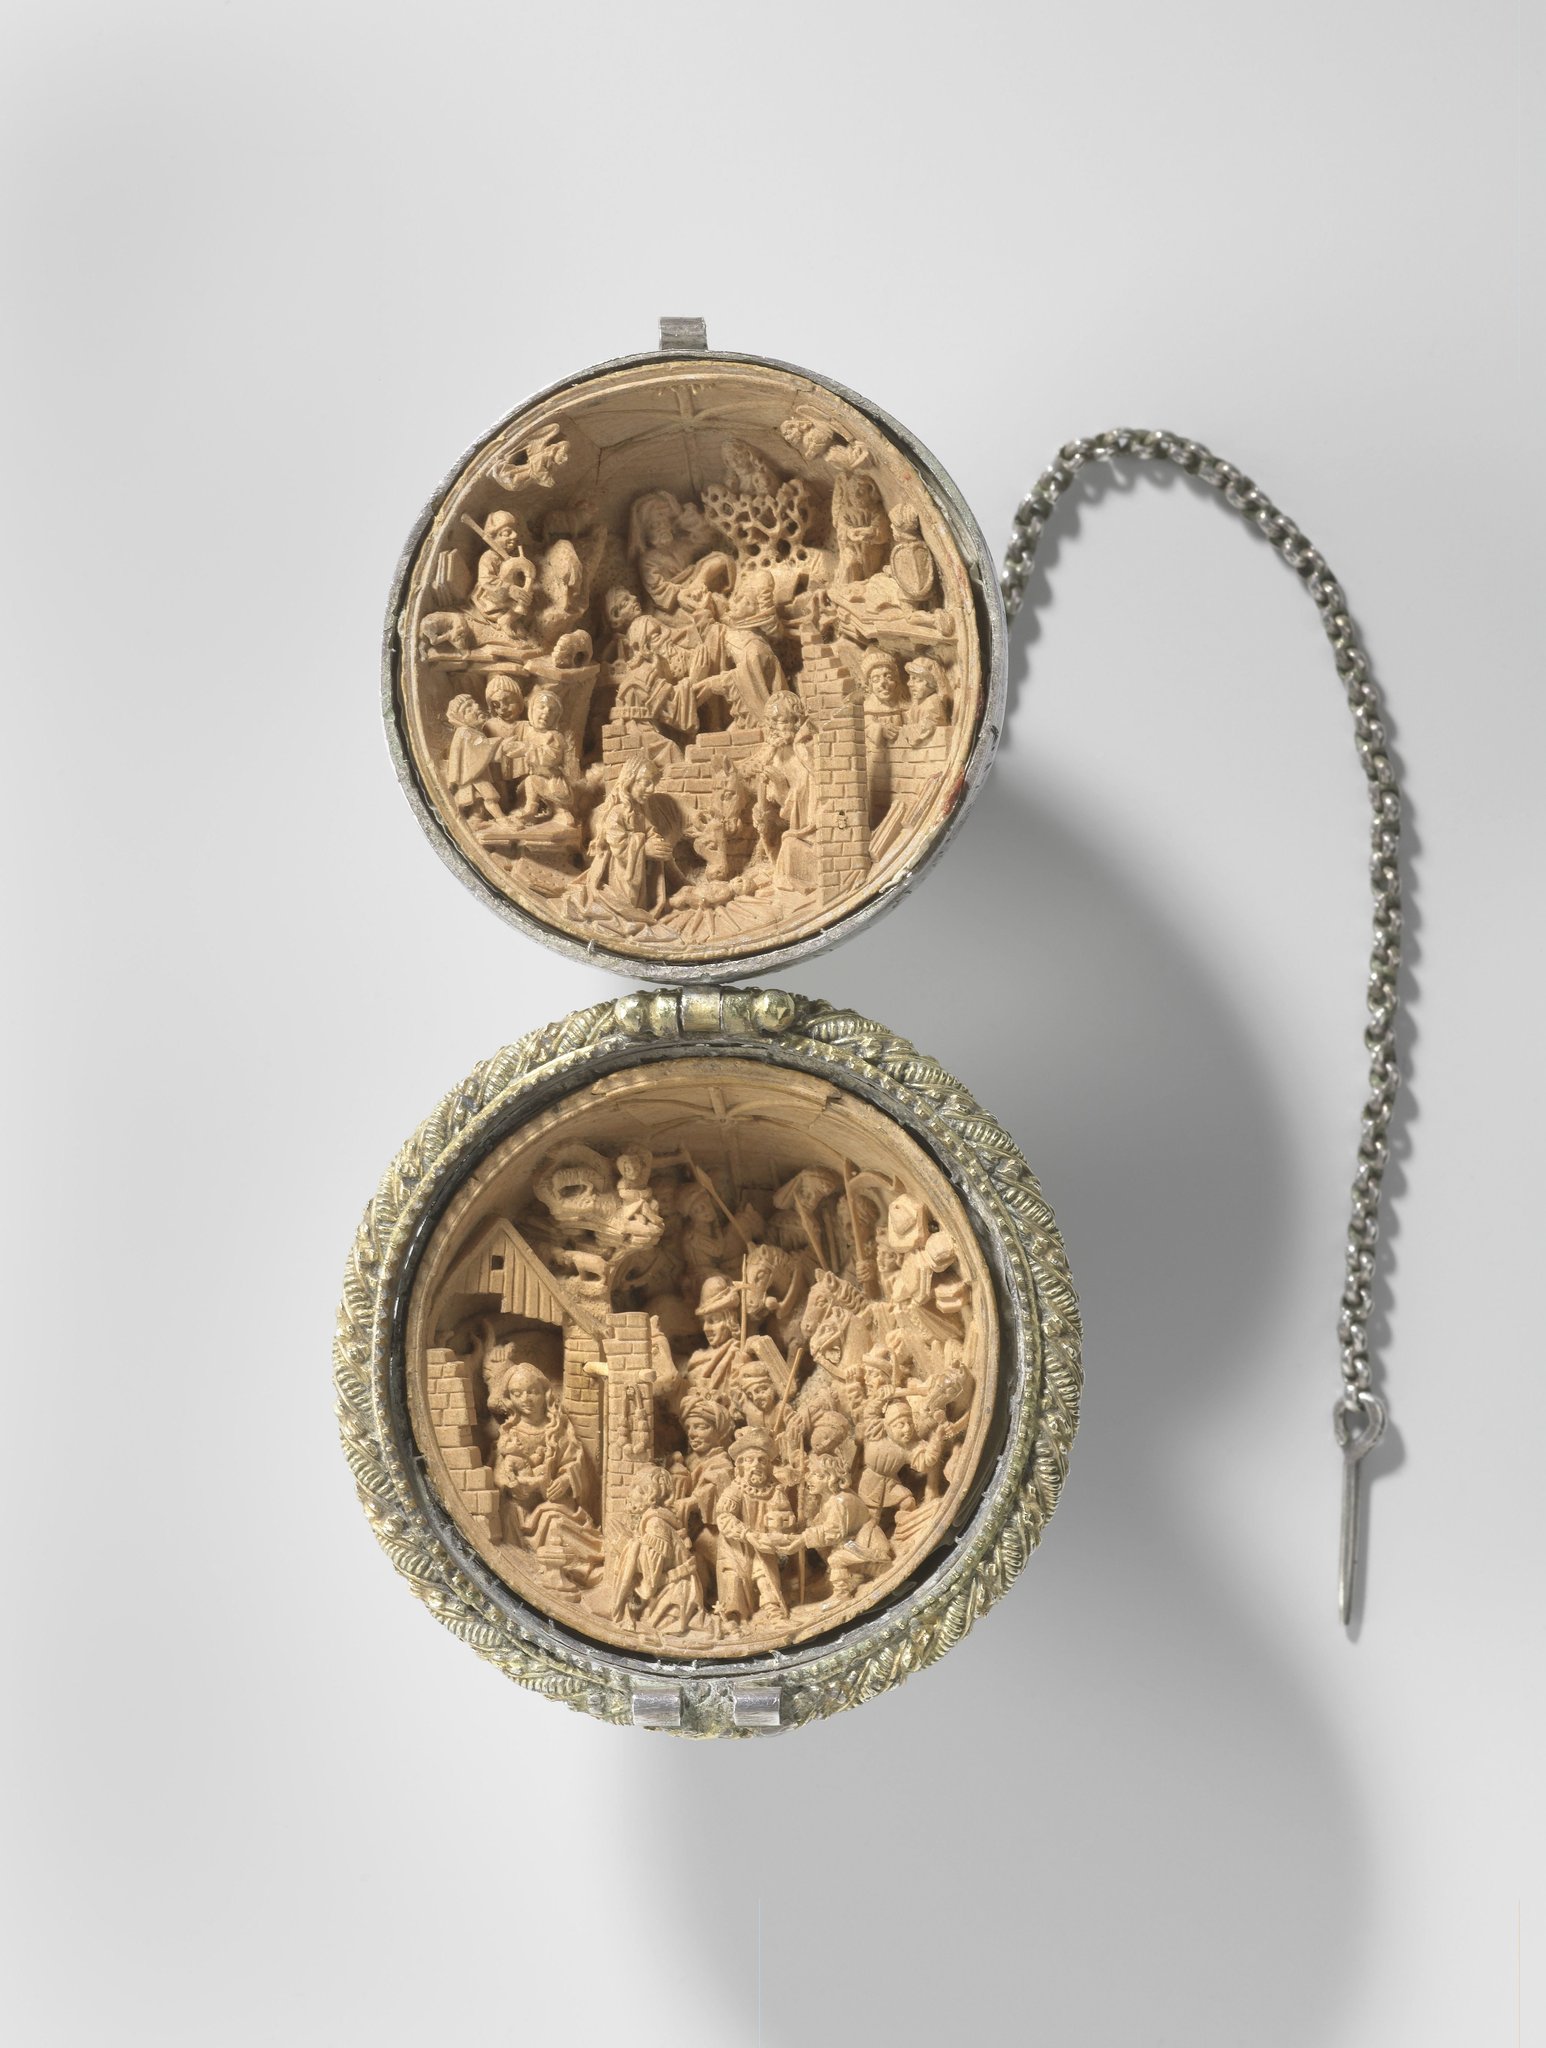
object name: prayer nut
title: Prayer Nut with The Nativity and The Adoration of the Magi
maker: adam dircksz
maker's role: goldsmith, sculptor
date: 1500-1530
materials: wood, gold, silver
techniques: engraving, carving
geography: delft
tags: the four elements, and ether, the fifth element, annunciation of christ's birth to the shepherds (and/or shepherdesses) at night; a host of singing angels in the air, eve (not in biblical context), moses taking off his sandals - ee - mary in the burning bush, the tiburtine sibyl and augustus: the sibyl reveals to the emperor a vision of the madonna in heaven, adoration of the kings: the wise men present their gifts to the christ-child (gold, frankincense and myrrh), mary, joseph and the new-born christ (nativity)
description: Een kleine in zilveren omhulsel gevatte gebedsnoot, bestaande uit twee miniatuur-reliëfs van de Geboorte van Christus en de Aanbidding der Koningen. Beide reliëfs zijn van buxushout en gemonteerd in twee scharnierende, zilveren halve bolletjes met sluiting en een klein kettinkje. Het zilveren bolletje is geheel gedecoreerd met uiterst verfijnd Gotisch graveerwerk: enerzijds dieren tussen bladeren (een aapje, een hond, een uil en andere vogels), anderzijds vijf figuurtjes: Eva, een man die in de grond schept met een schop, een man met een valk, een man die in het water staat en een man met een pook en vuur. Het zijn voorstellingen van de Vier Elementen (aarde, lucht, water en vuur) en tevens mogelijk verschillende maatschappelijke standen. De dieren vertegenwoordigen de 'omgekeerde wereld' van lust en kwaad. Rondom is het zilveren bolletje met een getordeerde draad van bleek goud versierd, terwijl op de boven- en onderzijde een gouden rozetje is.